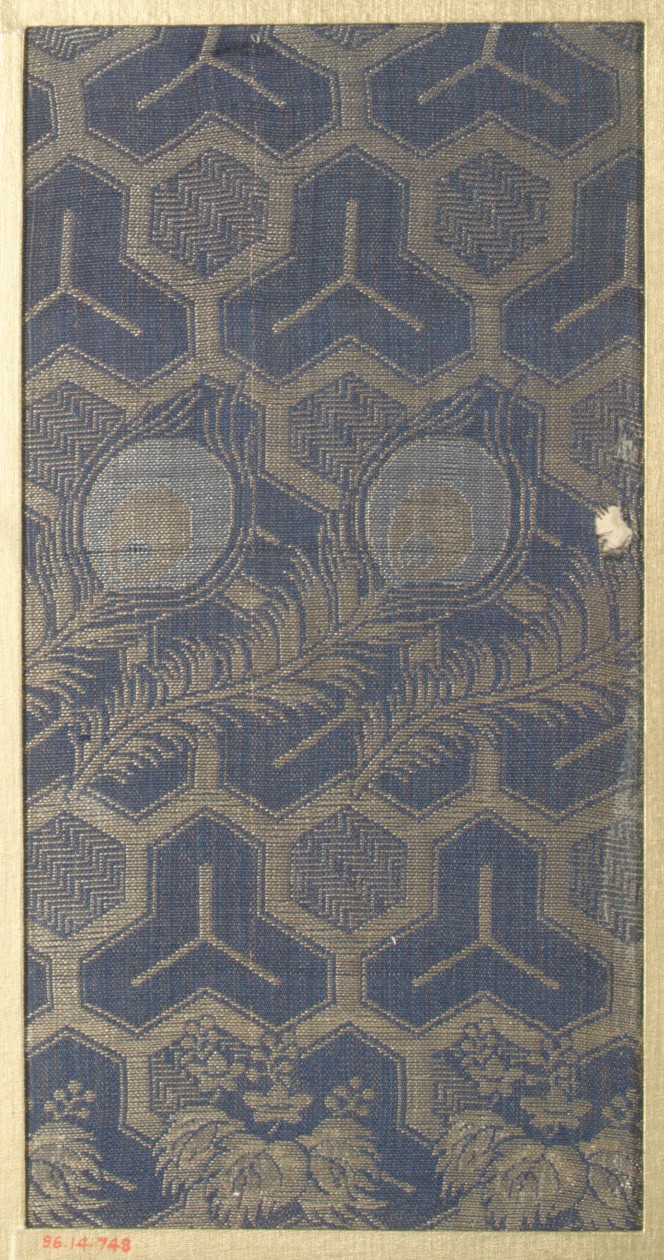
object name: piece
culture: japanese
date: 1701-1900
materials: silk